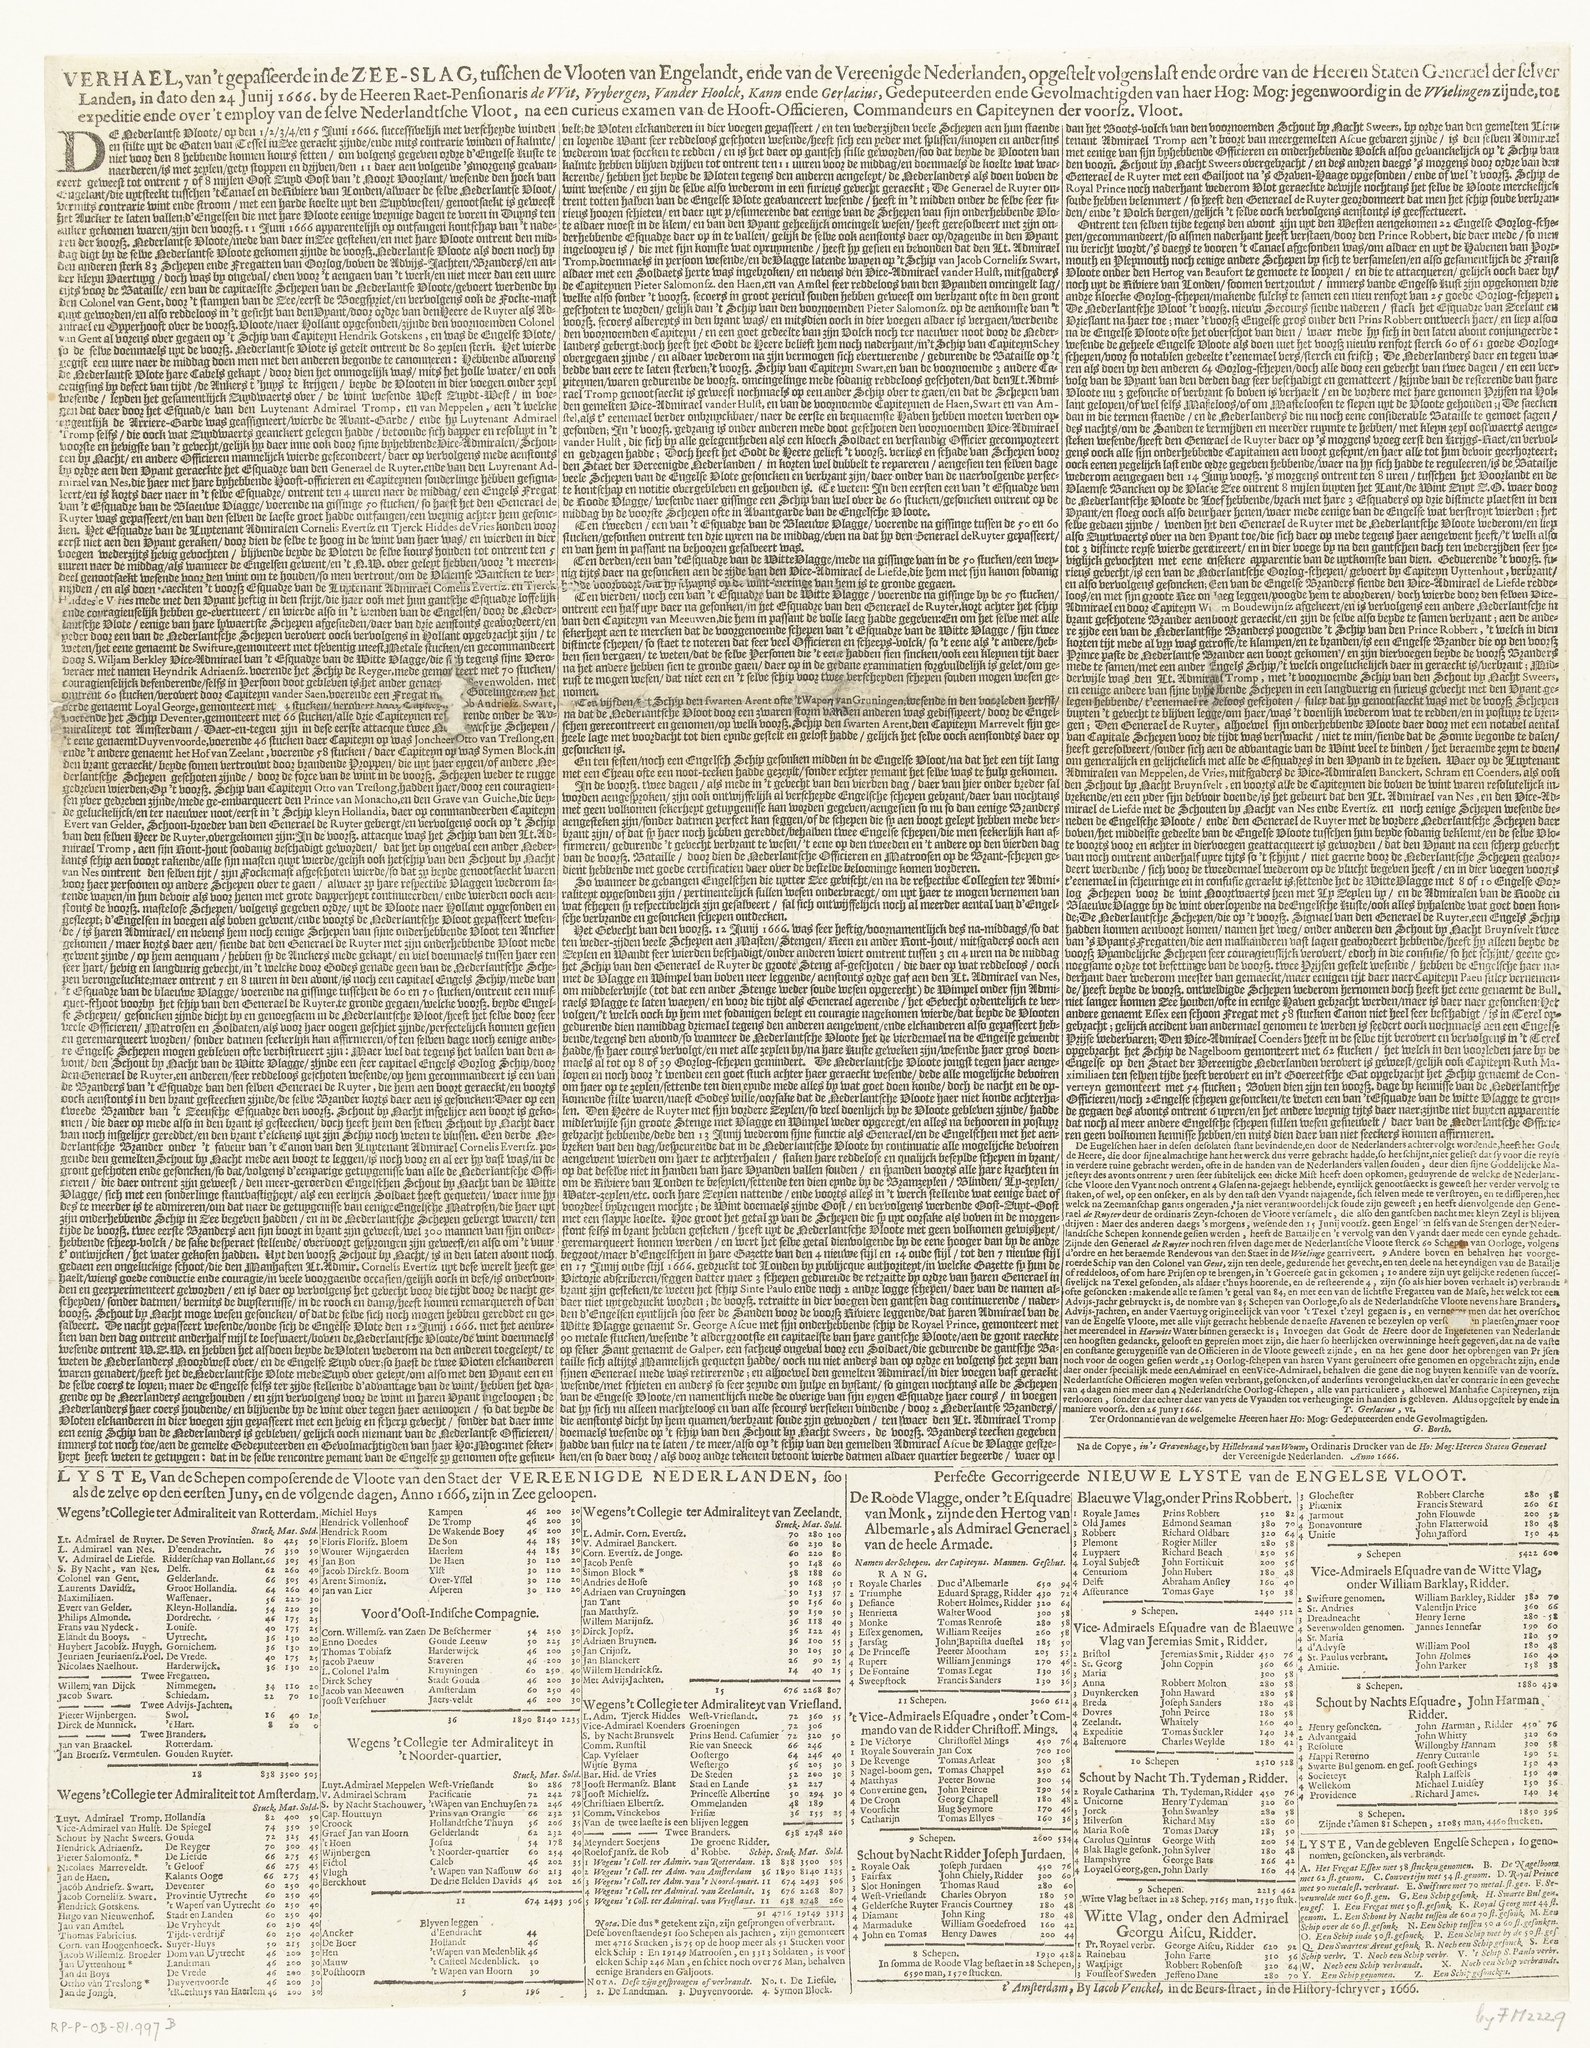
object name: print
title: Verhael, van 't gepasseerde in de Zee-Slag, tusschen de Vlooten van Engelandt, ende van de Vereenigde Nederlanden, opgestelt volgens last ende ordre van de Heeren Staten Generael der selver Landen, in dato den 24 Junij 1666 (...)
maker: jacob vinckel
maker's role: publisher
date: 1666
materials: paper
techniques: letterpress printing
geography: amsterdam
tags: flushing, michiel adriaenszoon de ruyter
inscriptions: date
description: Tekstblad bij de prent van de Vierdaagse Zeeslag tussen de Staatse vloot onder admiraal Michiel Adriaenszoon de Ruyter en de Engelse vloot onder admiraal George Monck, 11-14 juni 1666. Verhaal in 3 kolommen, daaronder lijsten van de kapiteins van de Nederlandse en de Engelse schepen die deelnamen aan de slag, de gezonken Nederlandse schepen 1-4 en de gezonken Engelse schepen A-Z.